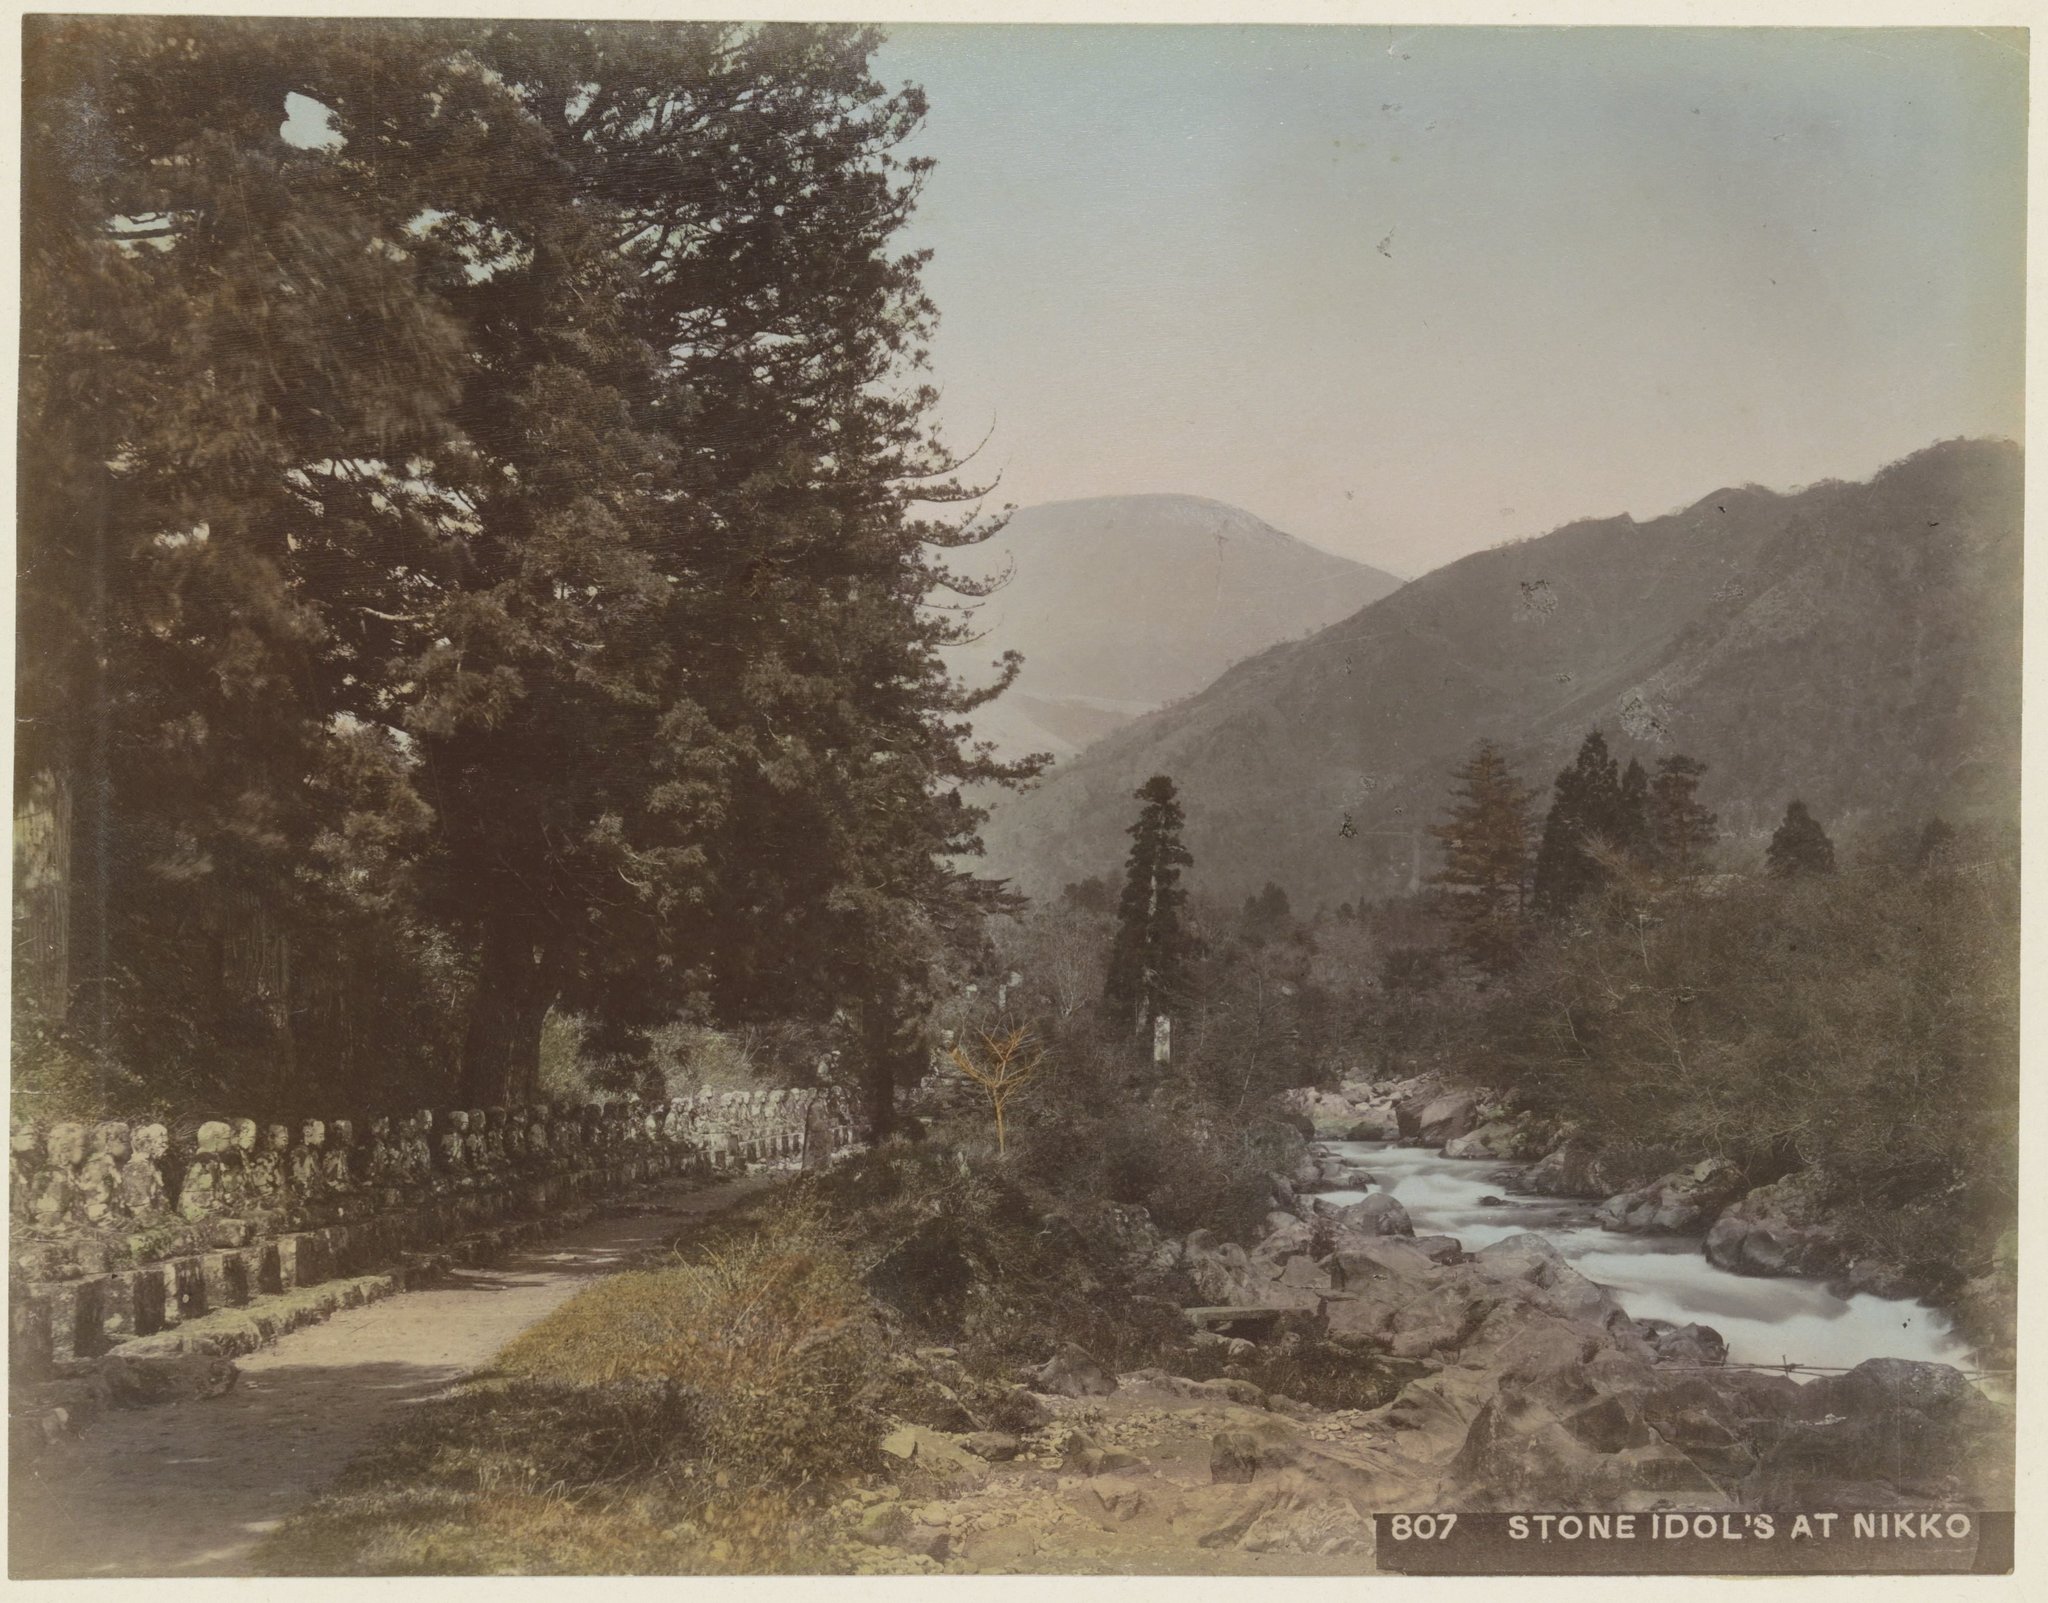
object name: photograph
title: Stenen beelden langs een rivier in de Kanmangafuchi-kloof bij Nikko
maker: Anonymous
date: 1870-1900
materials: cardboard, paper, photographic support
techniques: albumen print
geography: nikko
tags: piece of sculpture, reproduction of a piece of sculpture (+ sculpture), river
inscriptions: negative number: ‘807’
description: Onderdeel van Reisalbum met foto's van bezienswaardigheden in Japan.